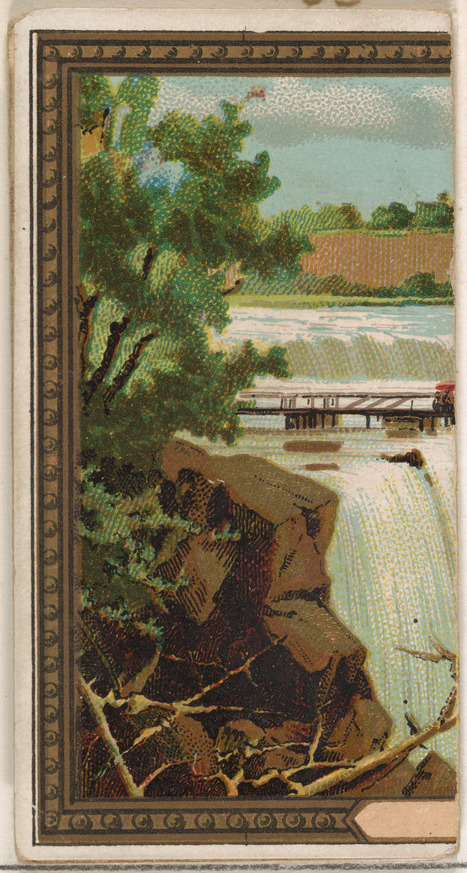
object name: print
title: Falls of Niagara, New York, from the Rulers, Flags, and Coats of Arms series (N126-2) issued by W. Duke, Sons & Co.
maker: w. duke, sons & co.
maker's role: publisher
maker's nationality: american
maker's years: 1870-1920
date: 1888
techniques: color lithograph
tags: waterfalls,rainbows